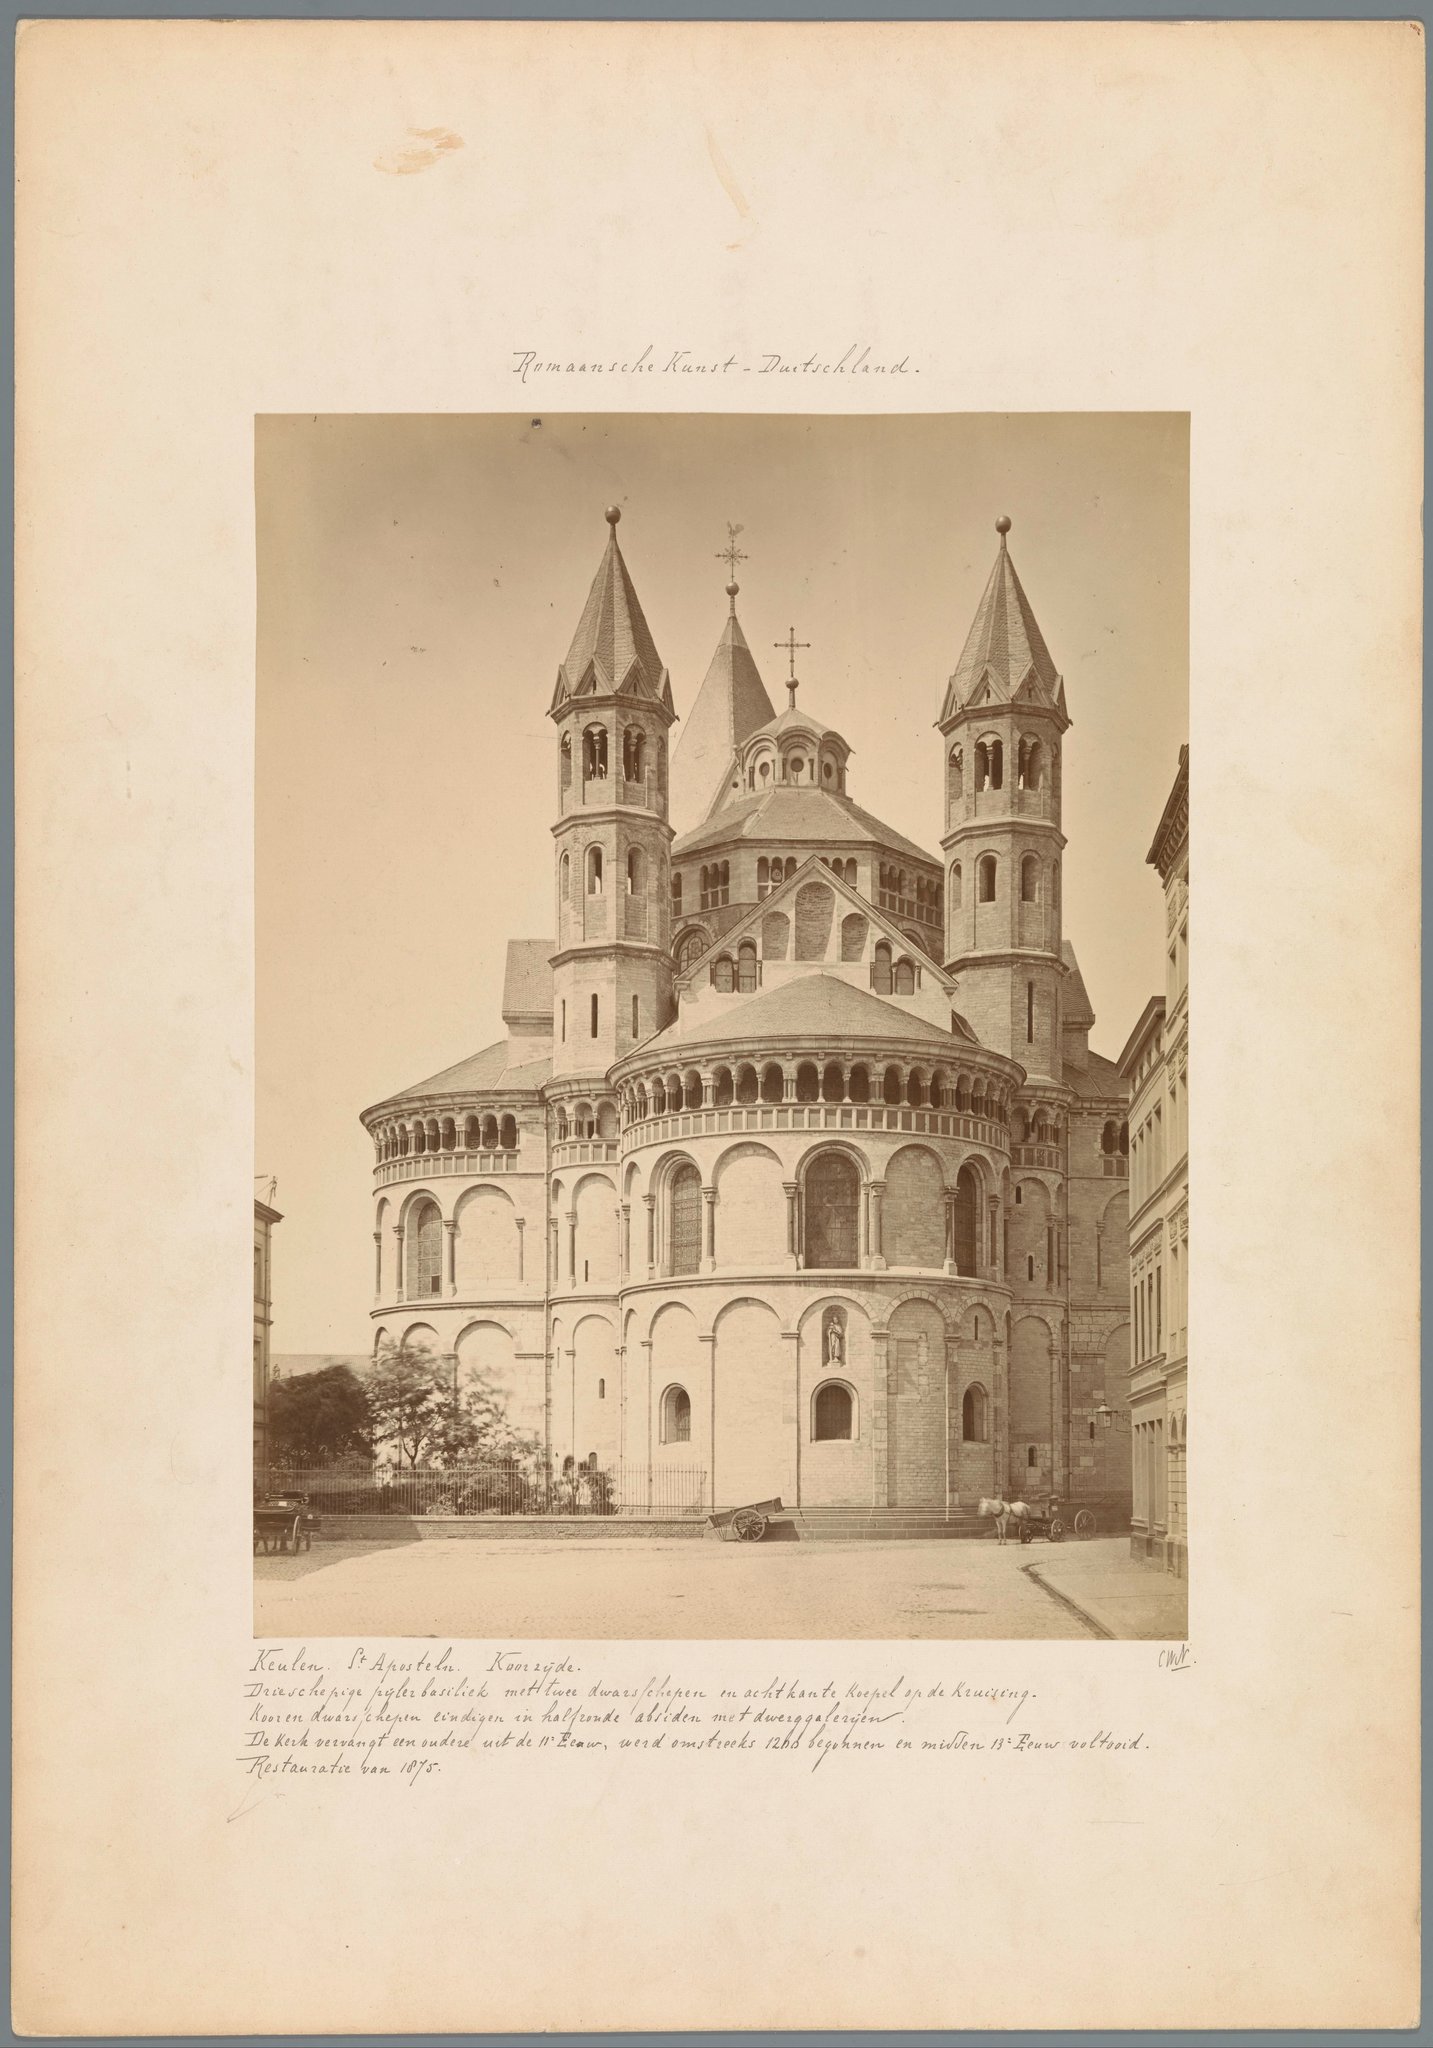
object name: photograph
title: Exterieur van de Apostelenkerk te Keulen, gezien vanaf de koorzijde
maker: Anonymous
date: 1875-1900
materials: cardboard, photographic support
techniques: albumen print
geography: cologne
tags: parts of church exterior and annexes: choir, two-wheeled, animal-drawn vehicle, façade (of house or building), parts of church exterior and annexes: tower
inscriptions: inscription: ‘CWN.’, inscription: ‘Romaansche Kunst - Duitschland. Keulen (...) Restauratie van 1875.’, collector's mark: ‘INSTITUUT VOOR KUNST- NIJVERHEIDSONDERWIJS GABRIËL METSUSTRAAT No. 16. AMSTERDAM’, collector's mark: ‘KUNSTNIJVERHEIDSCHOOL QUELLINUS AMSTERDAM FRANS HALSSTRAAT 14.’